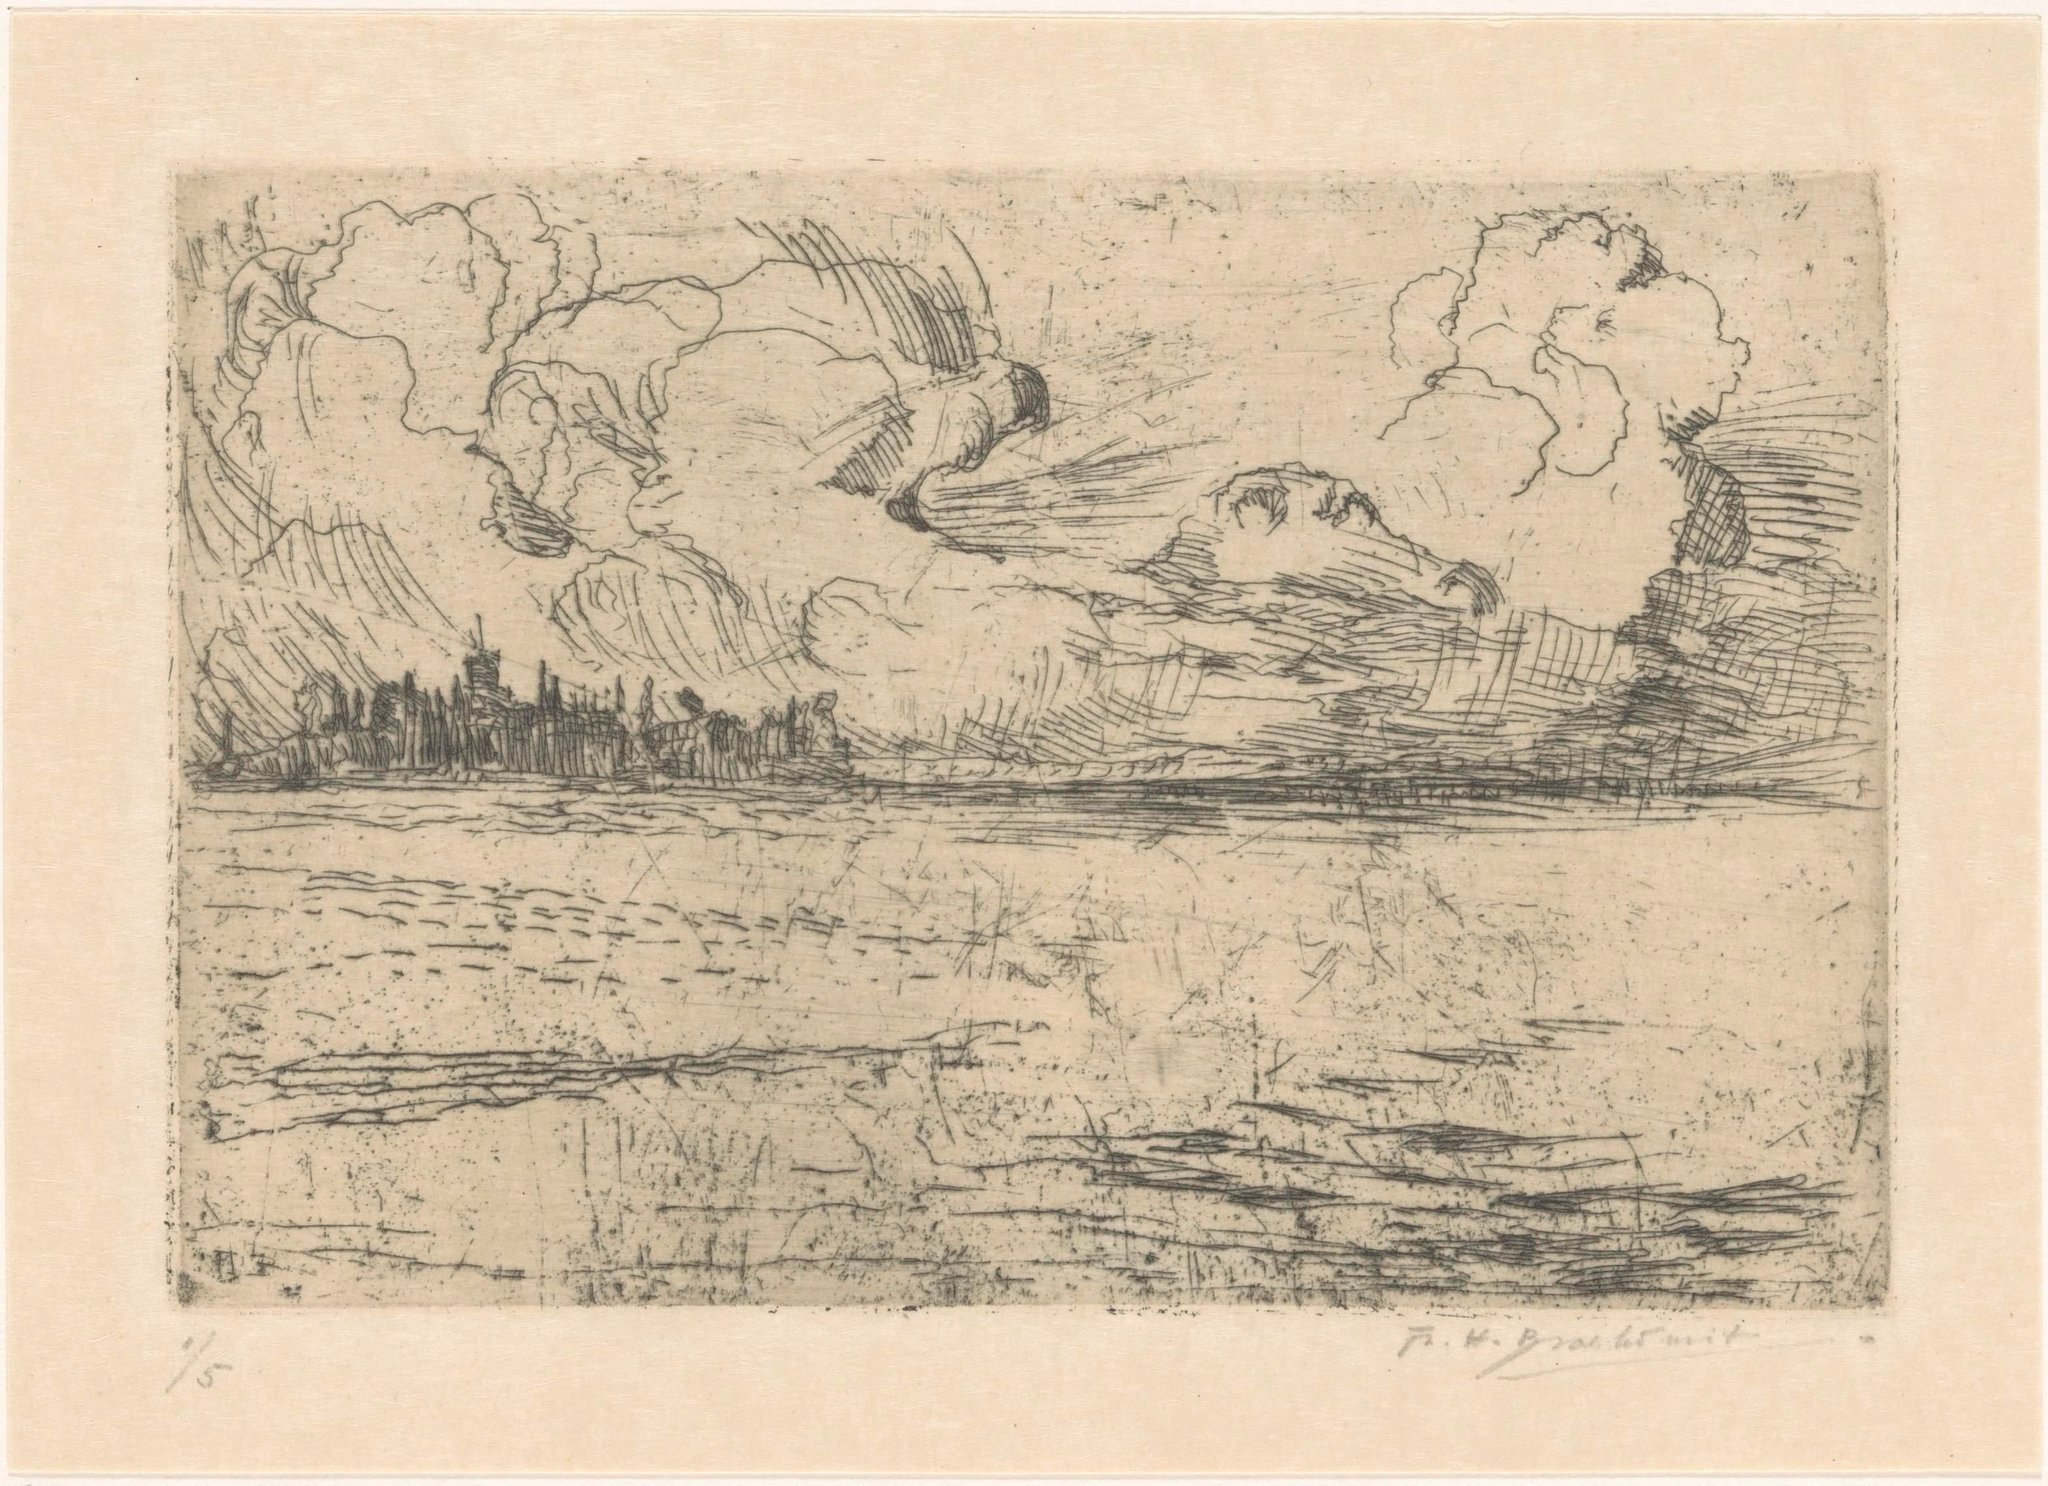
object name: print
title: Gardameer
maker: frederika henriëtte broeksmit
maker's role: draughtsman, print maker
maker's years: 1875-1945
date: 1885-1931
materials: paper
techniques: etching, intaglio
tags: prospect of village, silhouette of village, lake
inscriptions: collector's mark: Lugt 2228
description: De contouren van een nederzetting aan een meer.